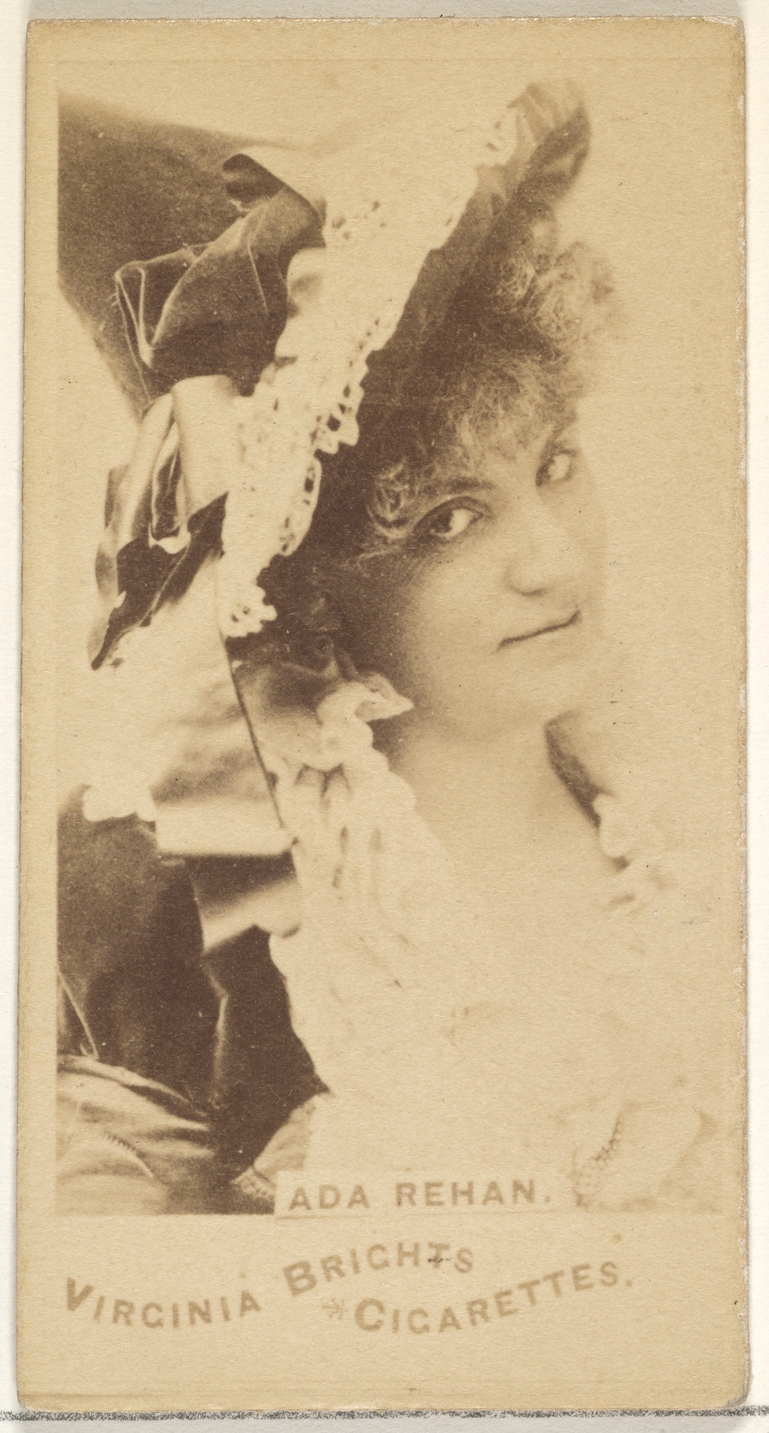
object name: photograph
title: Ada Rehan, from the Actors and Actresses series (N45, Type 1) for Virginia Brights Cigarettes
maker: allen & ginter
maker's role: publisher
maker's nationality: american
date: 1888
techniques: albumen silver print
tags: portraits,women,actresses